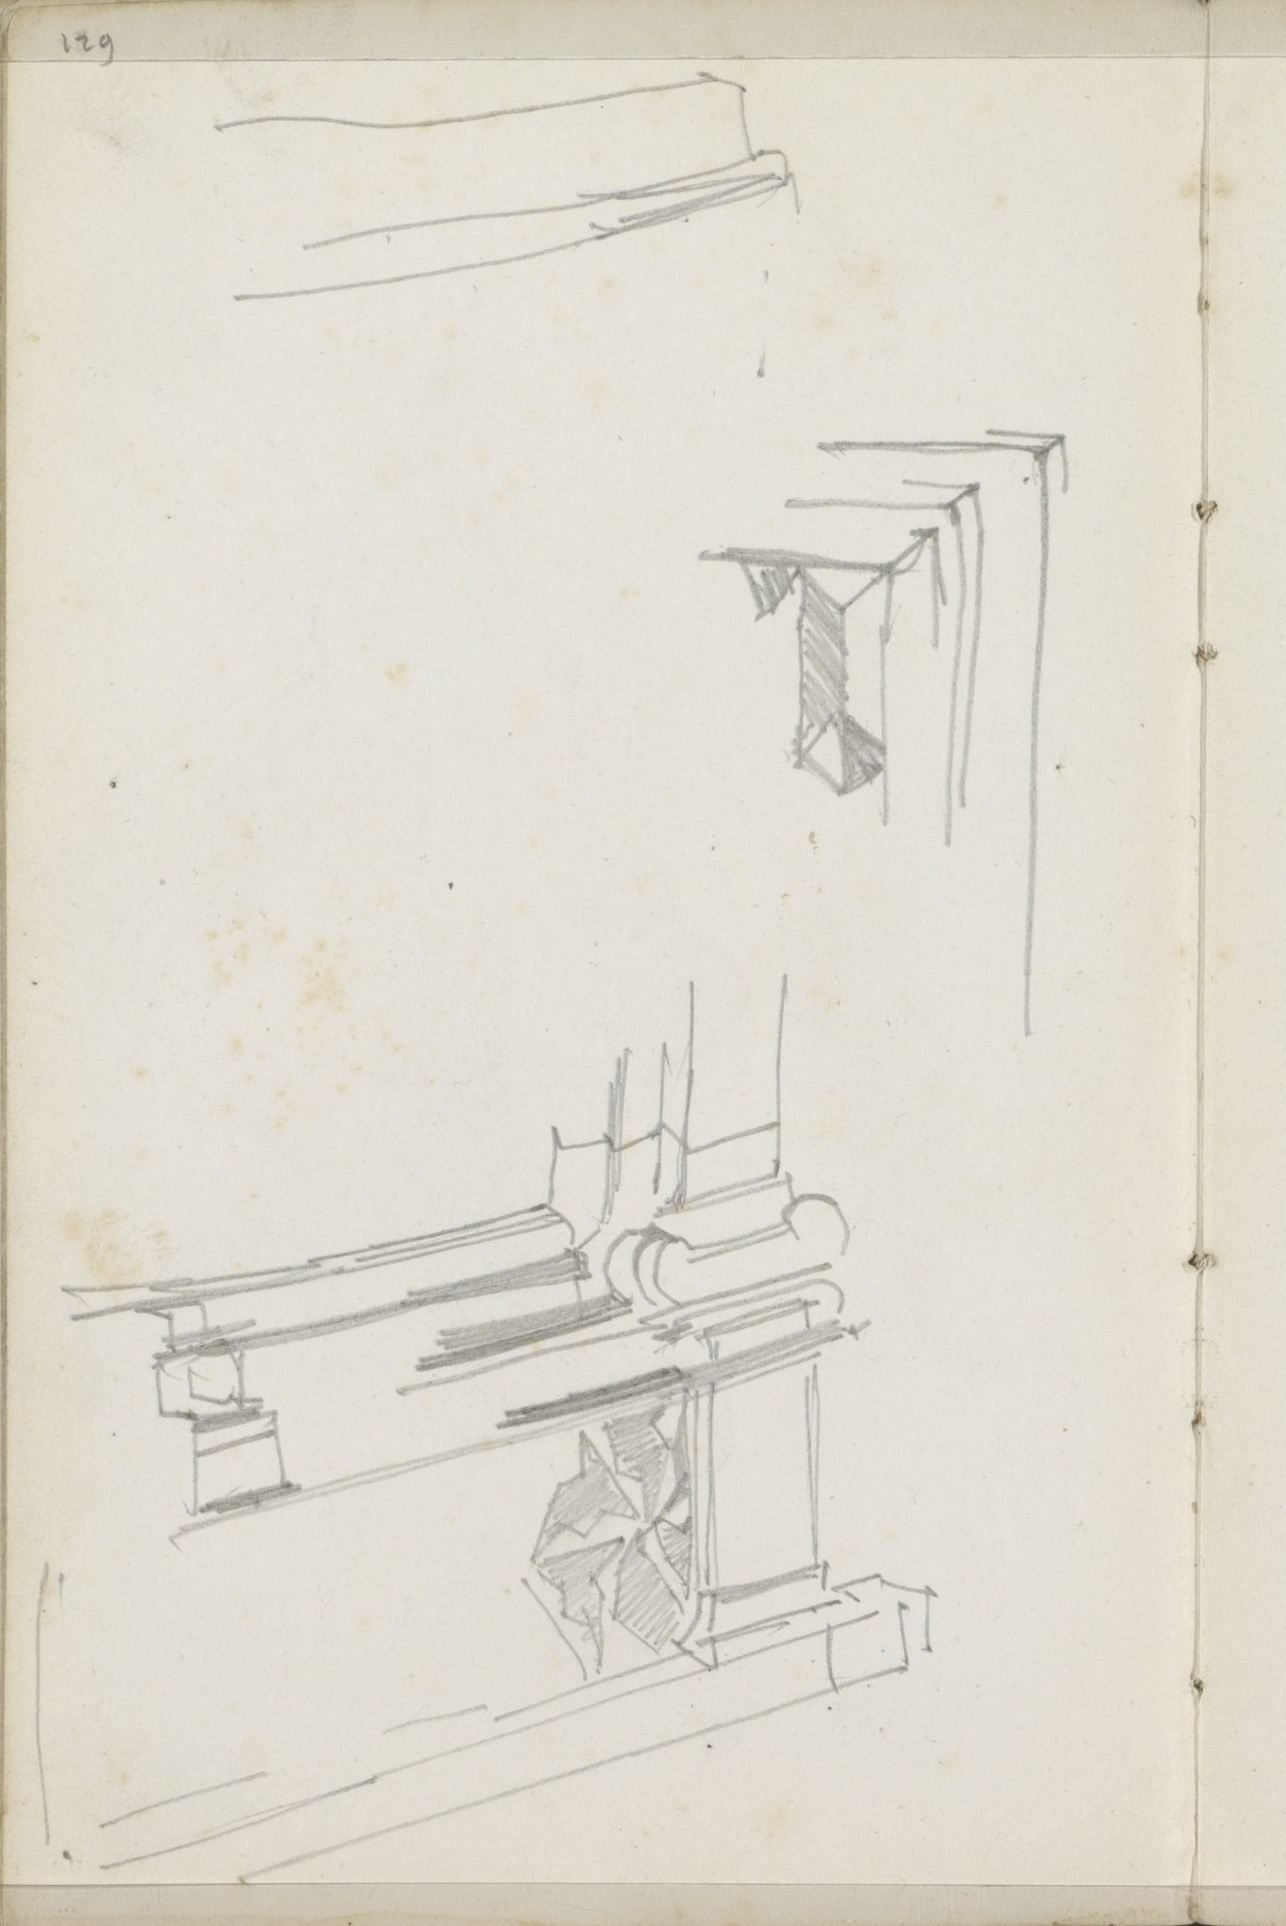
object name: sketchbook leaf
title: Architectuurstudies, mogelijk van een portaal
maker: george hendrik breitner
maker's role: draughtsman, painter, print maker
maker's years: 1857-1923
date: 1880-1882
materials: paper, pencil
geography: south holland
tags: monumental door, porch, 'aediculum', architectural detail, civic architecture; edifices; dwellings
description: Pagina 129 uit een schetsboek met 72 bladen.